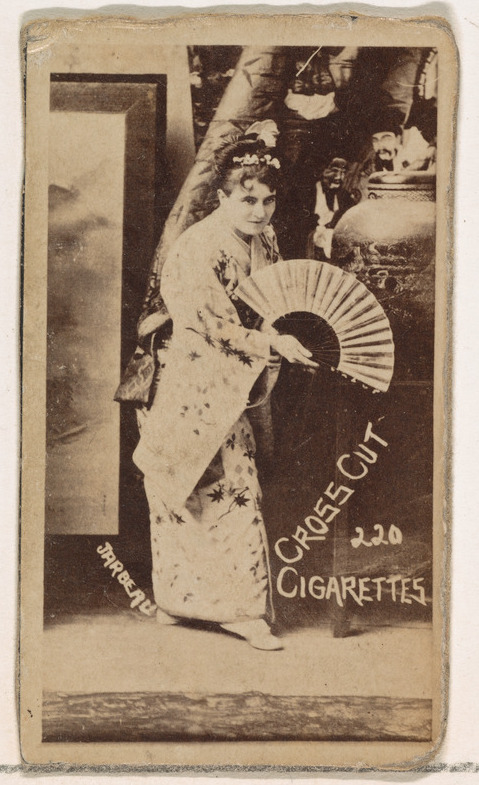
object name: print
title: Card Number 220, Jarbeau, from the Actors and Actresses series (N145-1) issued by Duke Sons & Co. to promote Cross Cut Cigarettes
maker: w. duke, sons & co.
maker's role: publisher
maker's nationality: american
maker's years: 1870-1920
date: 1880-1889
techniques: albumen silver print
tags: portraits,women,actresses